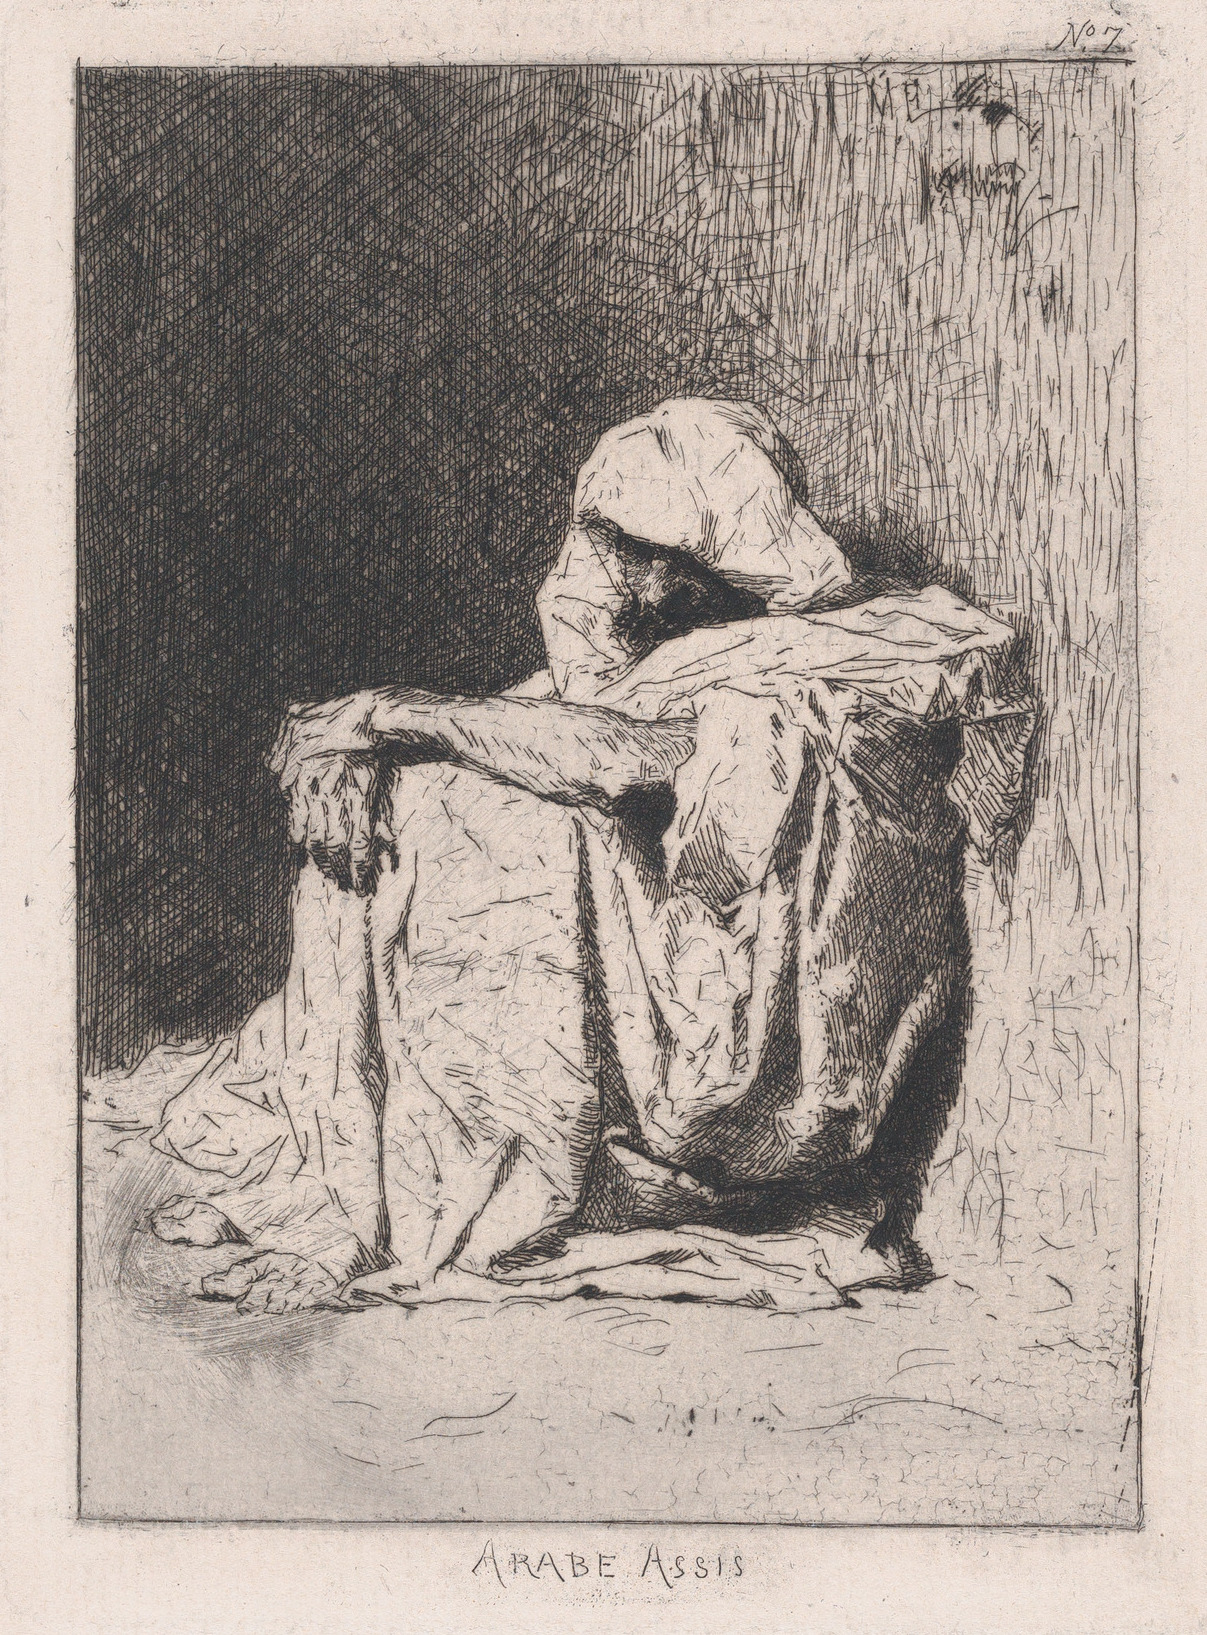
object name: print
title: An Arabic man seated on the ground, head partly covered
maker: mariano fortuny, 1838–1874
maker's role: artist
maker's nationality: spanish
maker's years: 1838-1874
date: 1860-1862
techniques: etching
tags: men